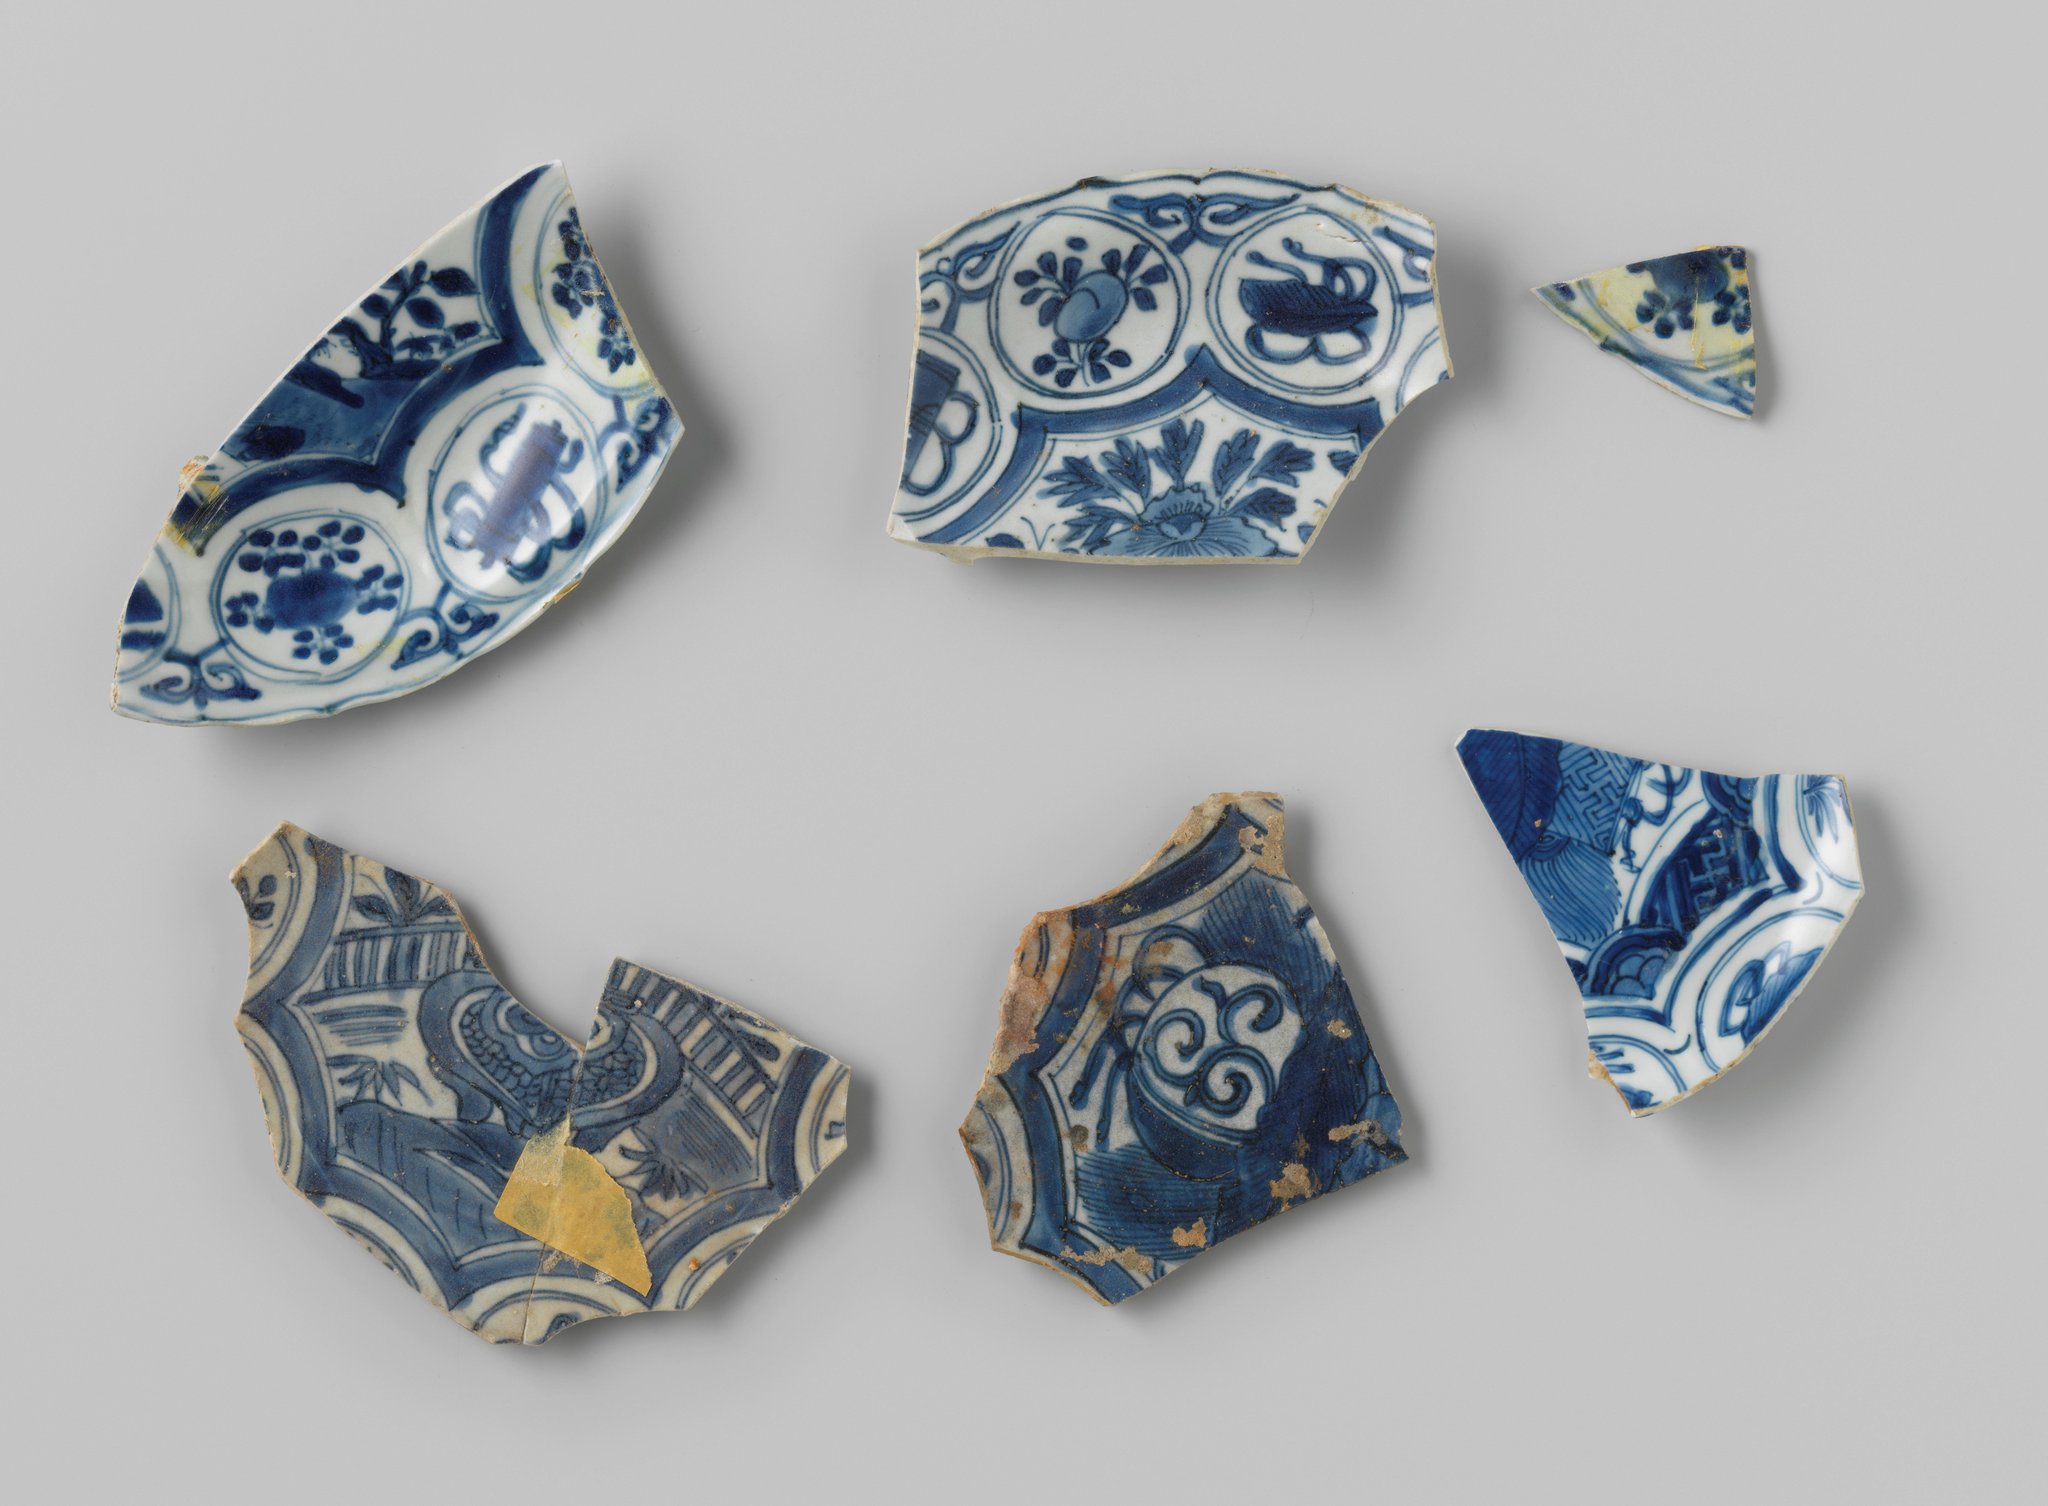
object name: sherd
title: Scherven van kraakporseleinen borden uit V.O.C.-schip de 'Witte Leeuw'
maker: Anonymous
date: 1613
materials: bone china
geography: jingdezhen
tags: verenigde oostindische compagnie, sint-helena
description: Scherven van kraakporseleinen borden uit V.O.C.-schip de 'Witte Leeuw'.